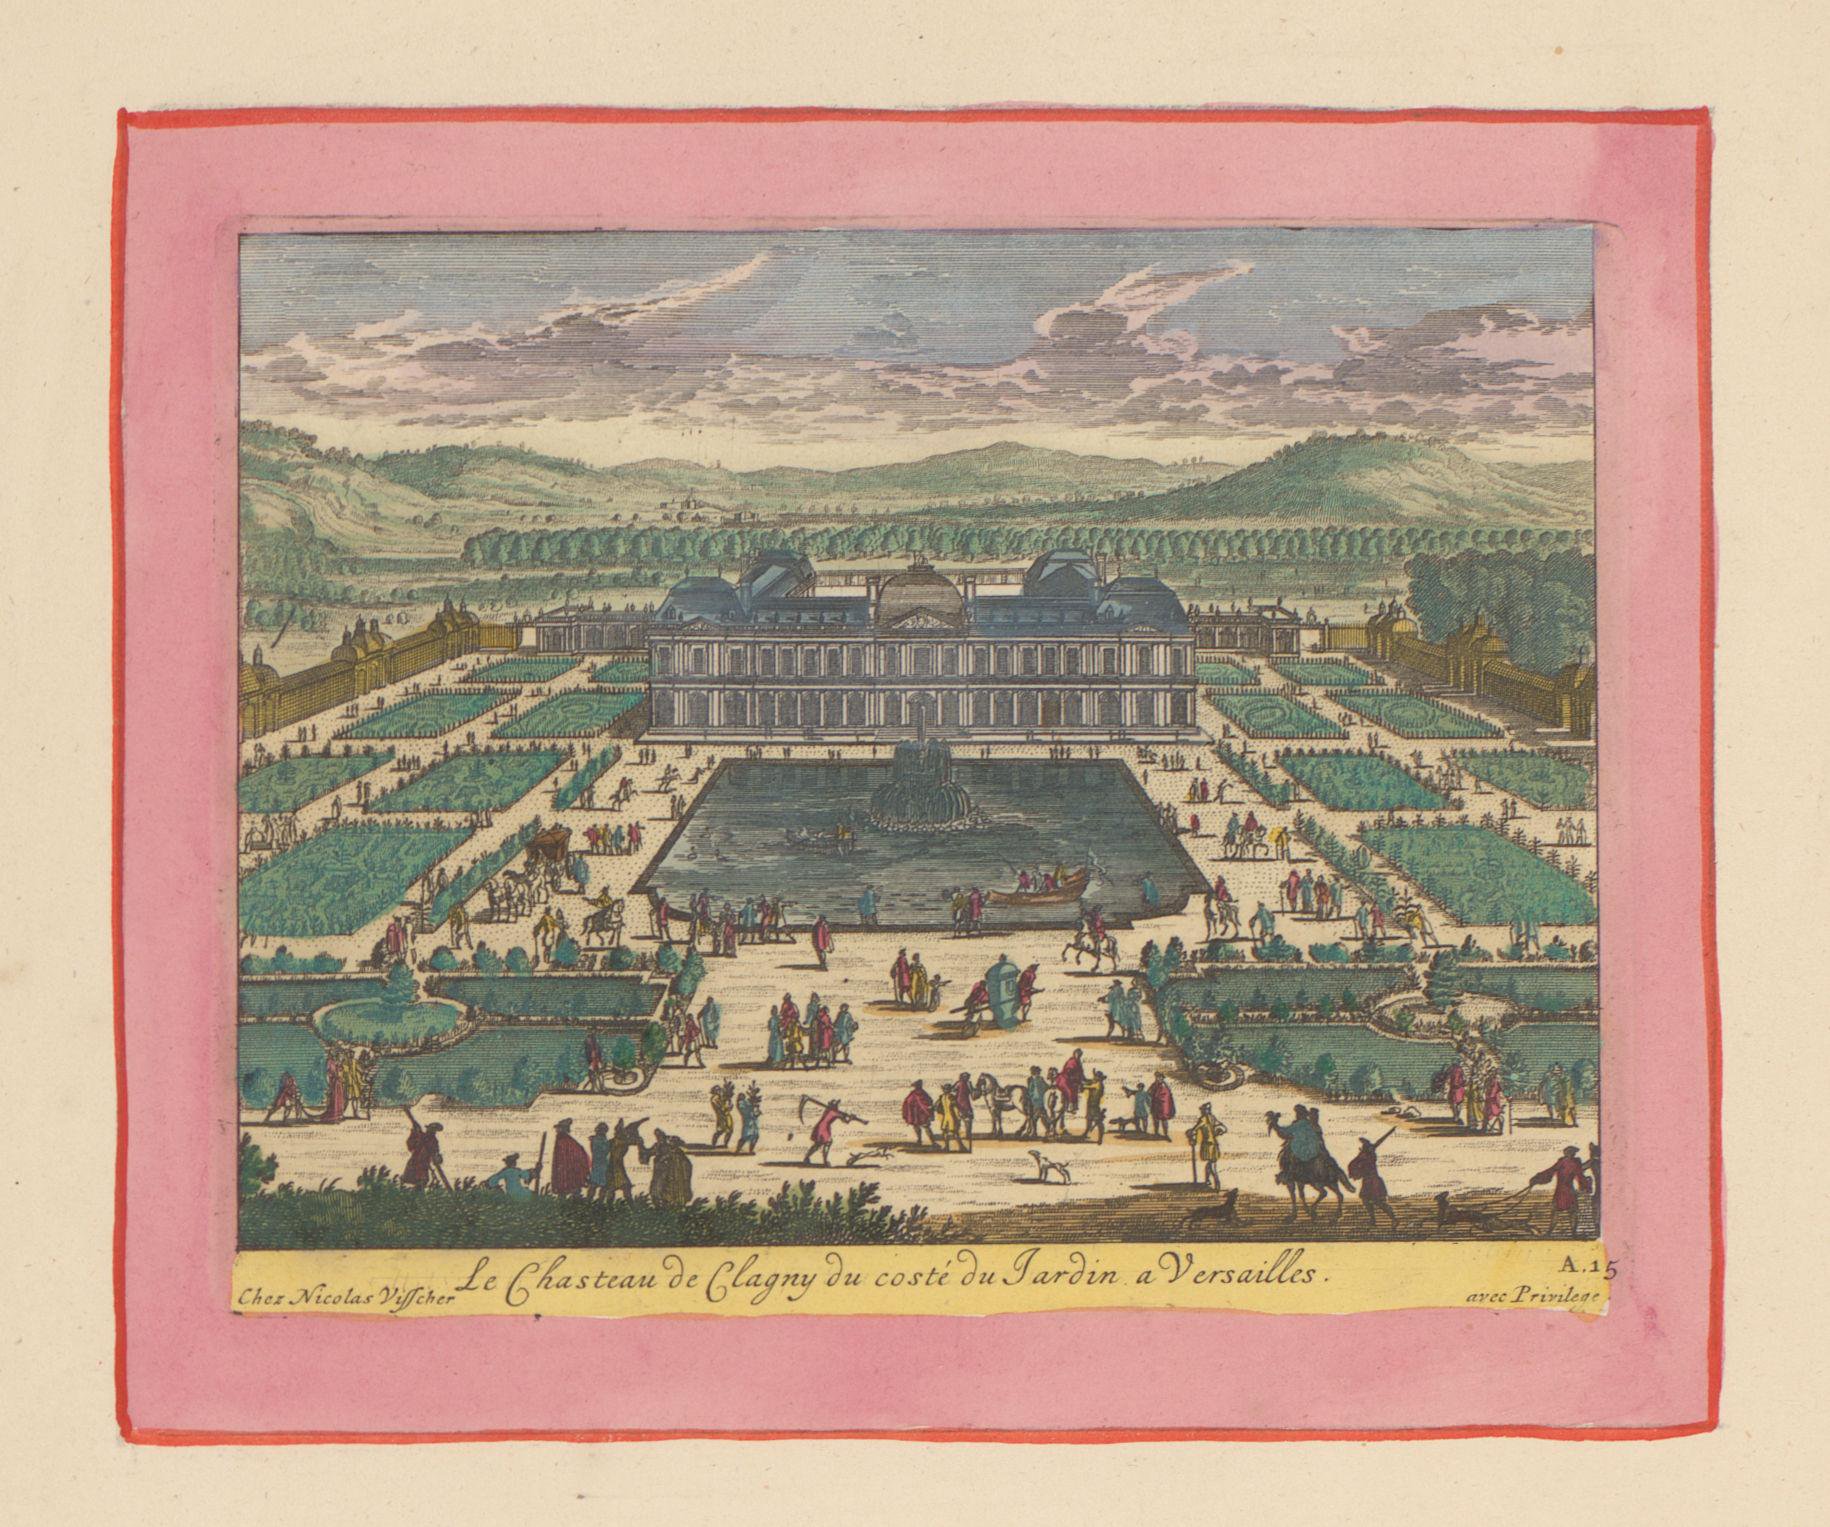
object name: print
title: Le Chasteau de Clagny du costé du Jardin a Versailles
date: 1686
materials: paper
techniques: etching, hand coloring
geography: amsterdam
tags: palace, french or architectonic garden; formal garden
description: Gezicht op Château de Clagny van de tuinzijde in vogelvluchtperspectief. Château de Clagny is gesitueerd ten noordoosten van het Paleis van Versailles. Rechtsonder het serienummer: A15. Prent maakt deel uit van een album.